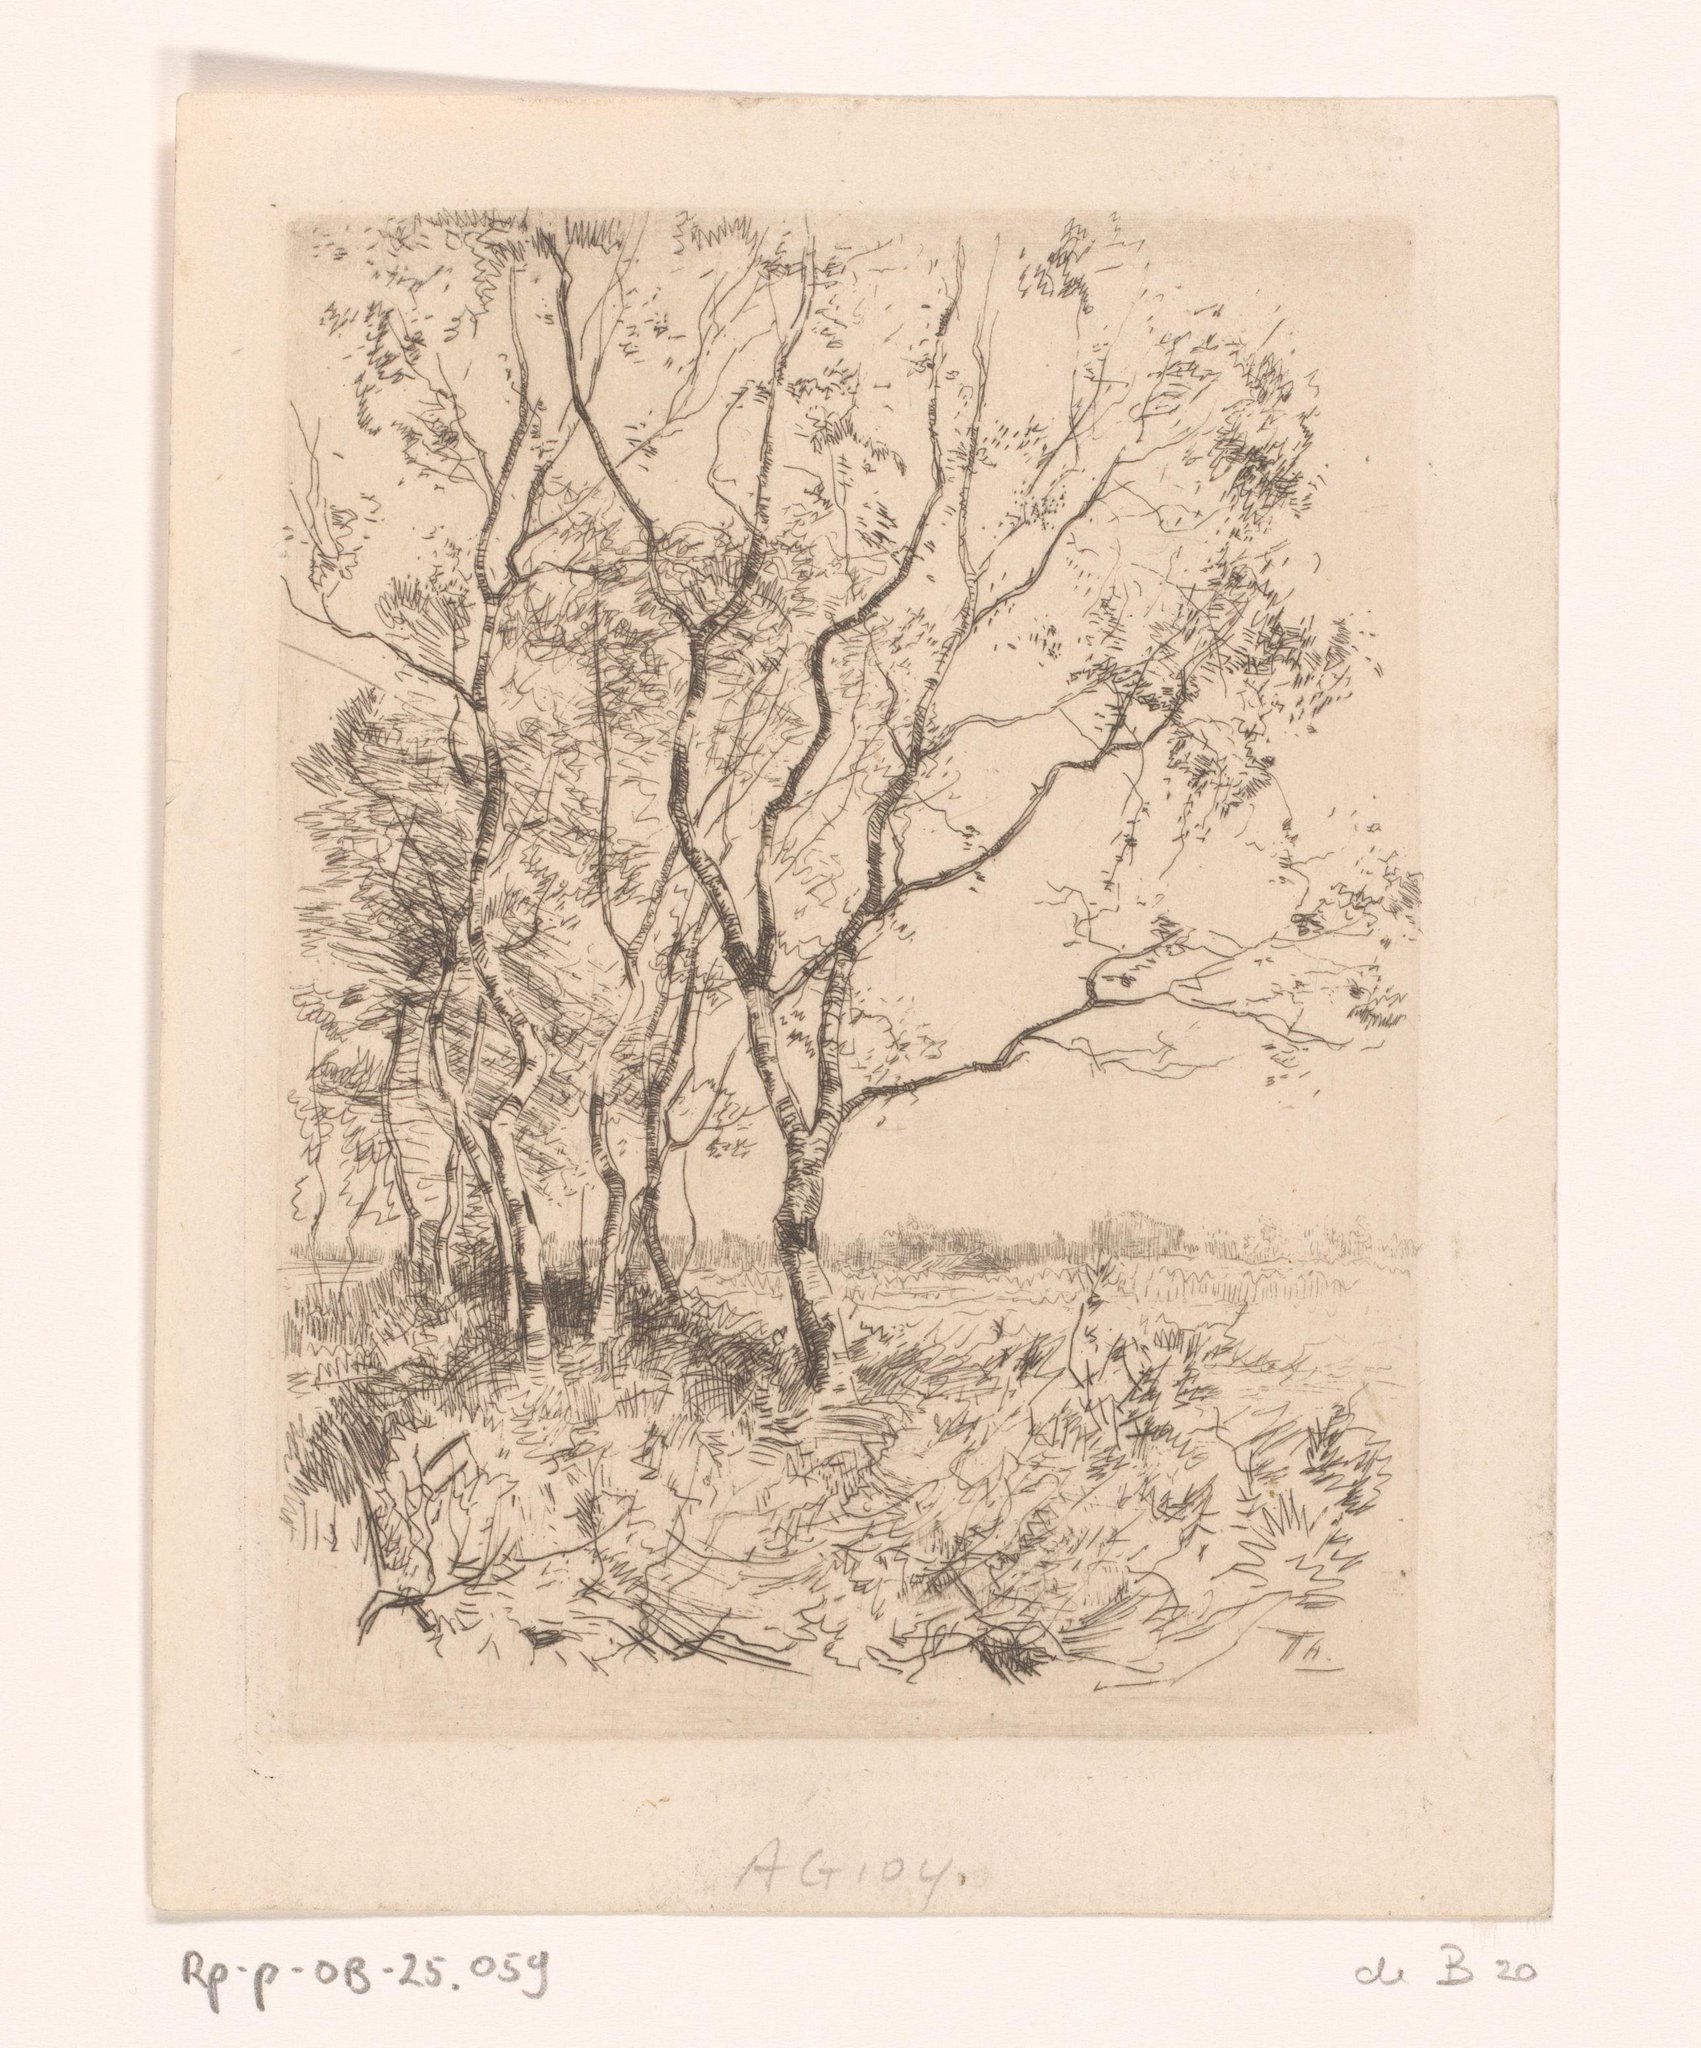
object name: print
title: Rij berken aan een weiland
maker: willem bastiaan tholen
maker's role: draughtsman, painter, print maker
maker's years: 1860-1931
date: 1888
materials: paper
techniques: etching, intaglio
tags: meadow, pasture, trees: birch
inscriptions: collector's mark: Lugt 2228